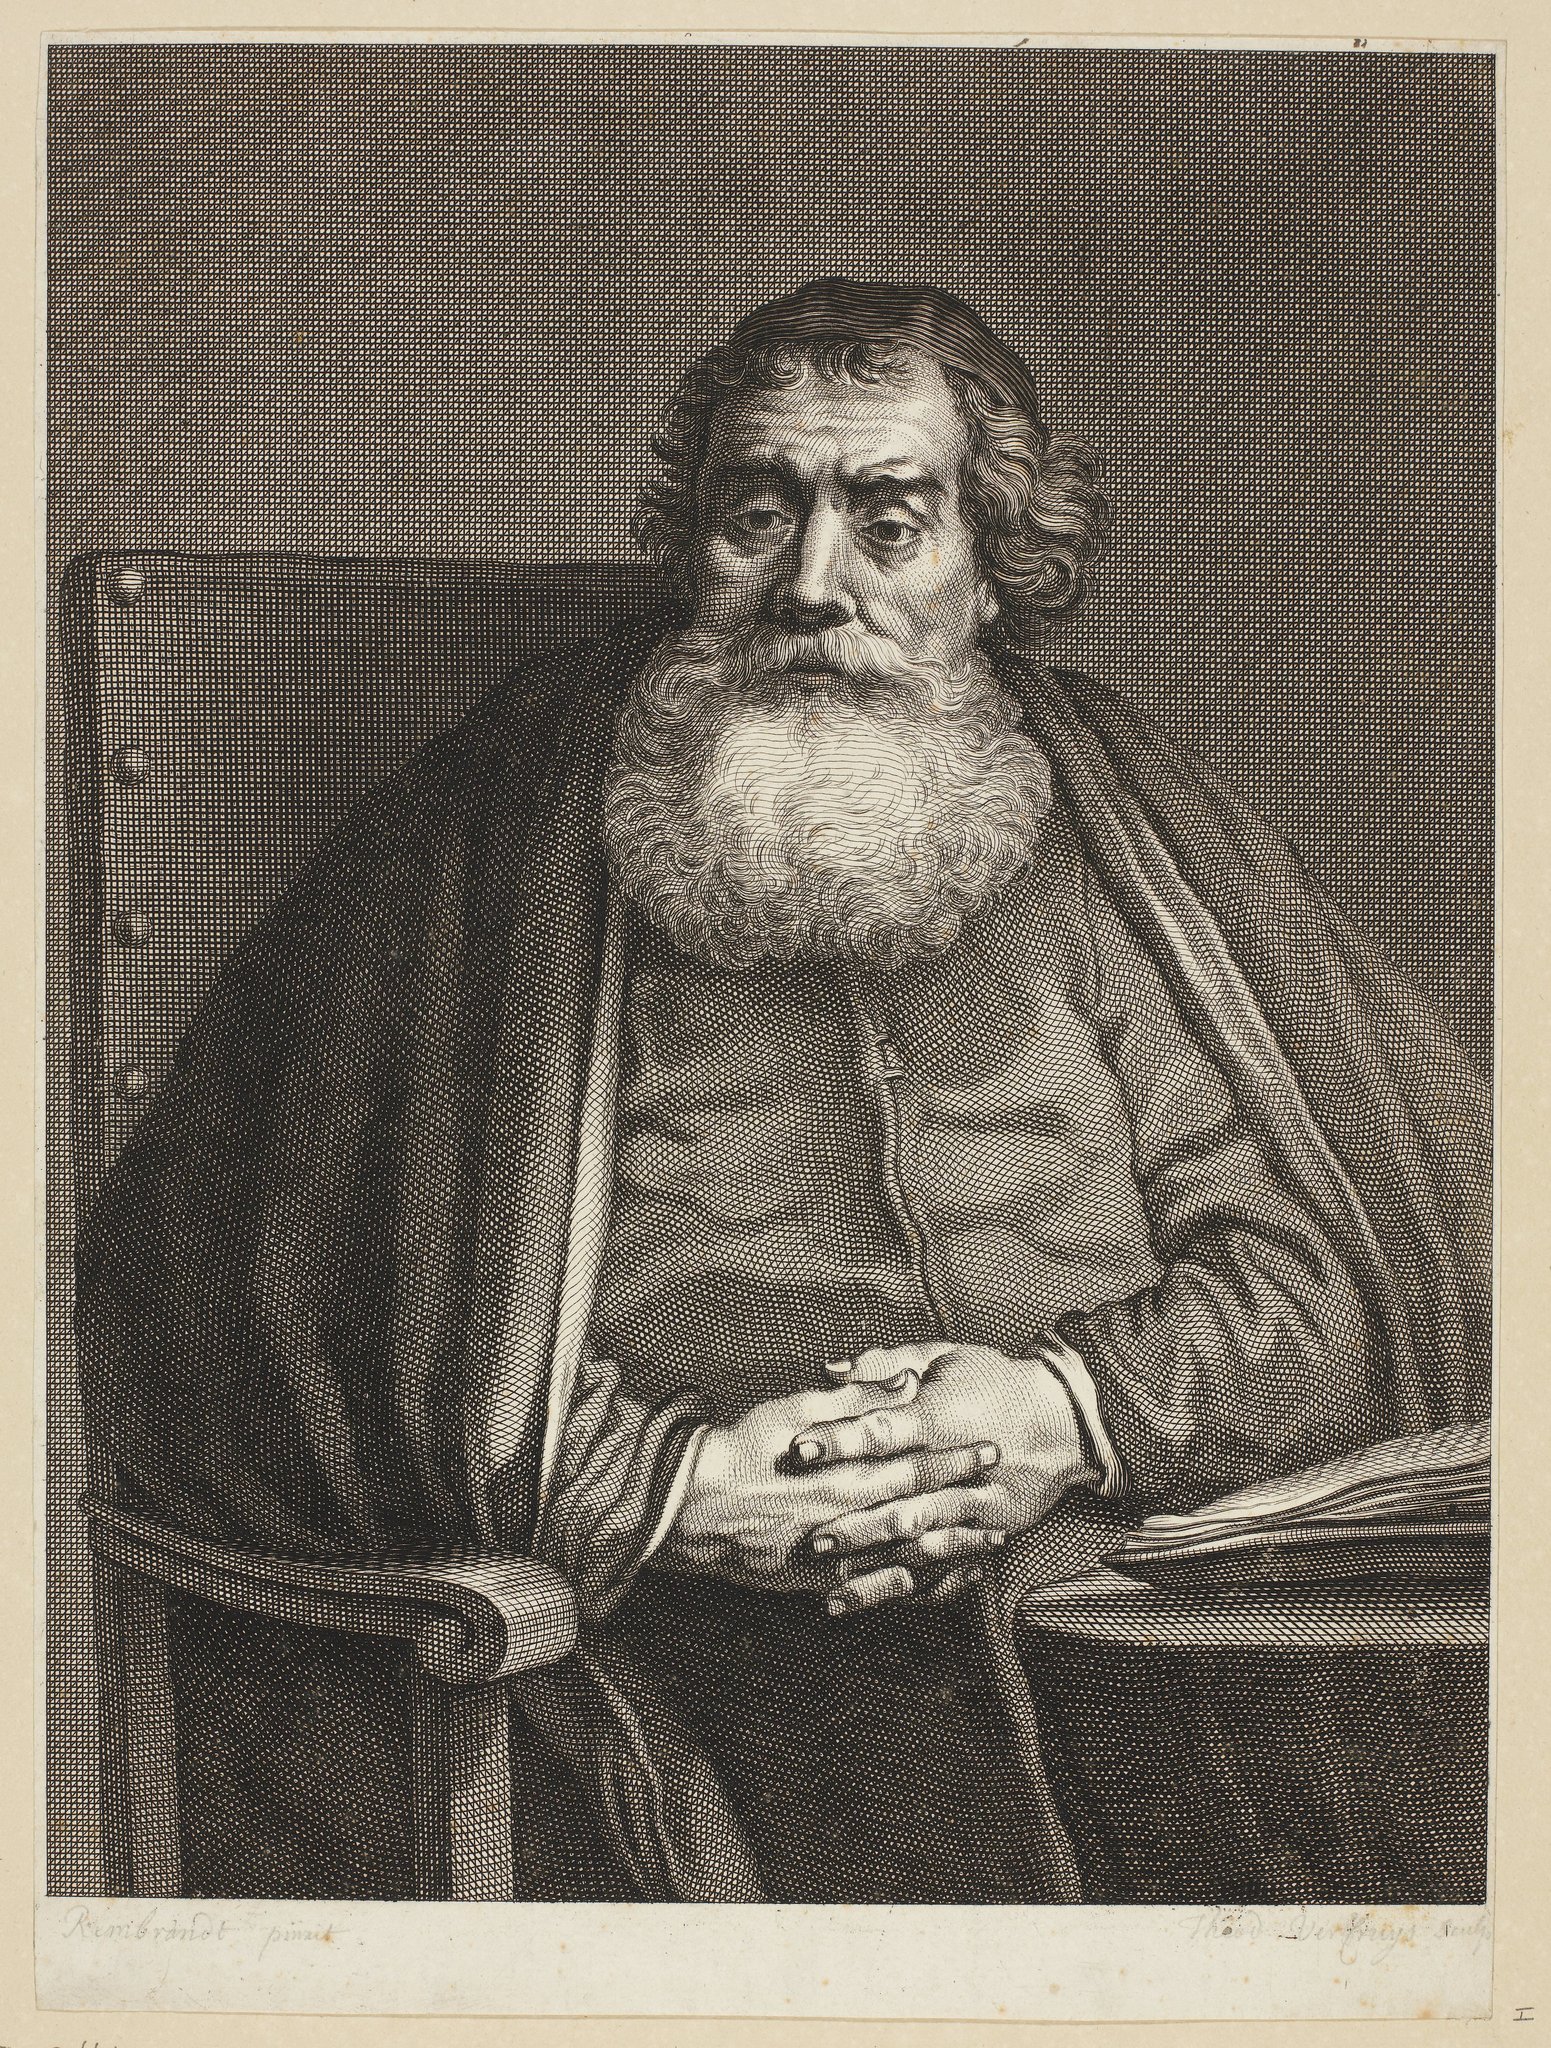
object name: print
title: Zittende man met baard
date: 1690-1739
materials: paper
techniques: engraving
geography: italy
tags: hands folded with fingers knit, old man, rabbi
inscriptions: collector's mark: Lugt 240, inscription: ‘Rembrandt pinx Theodore Vercruys sc du cabinet du gran duc’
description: Zittende man (rabbi) met baard, met gevouwen handen achter een tafel.